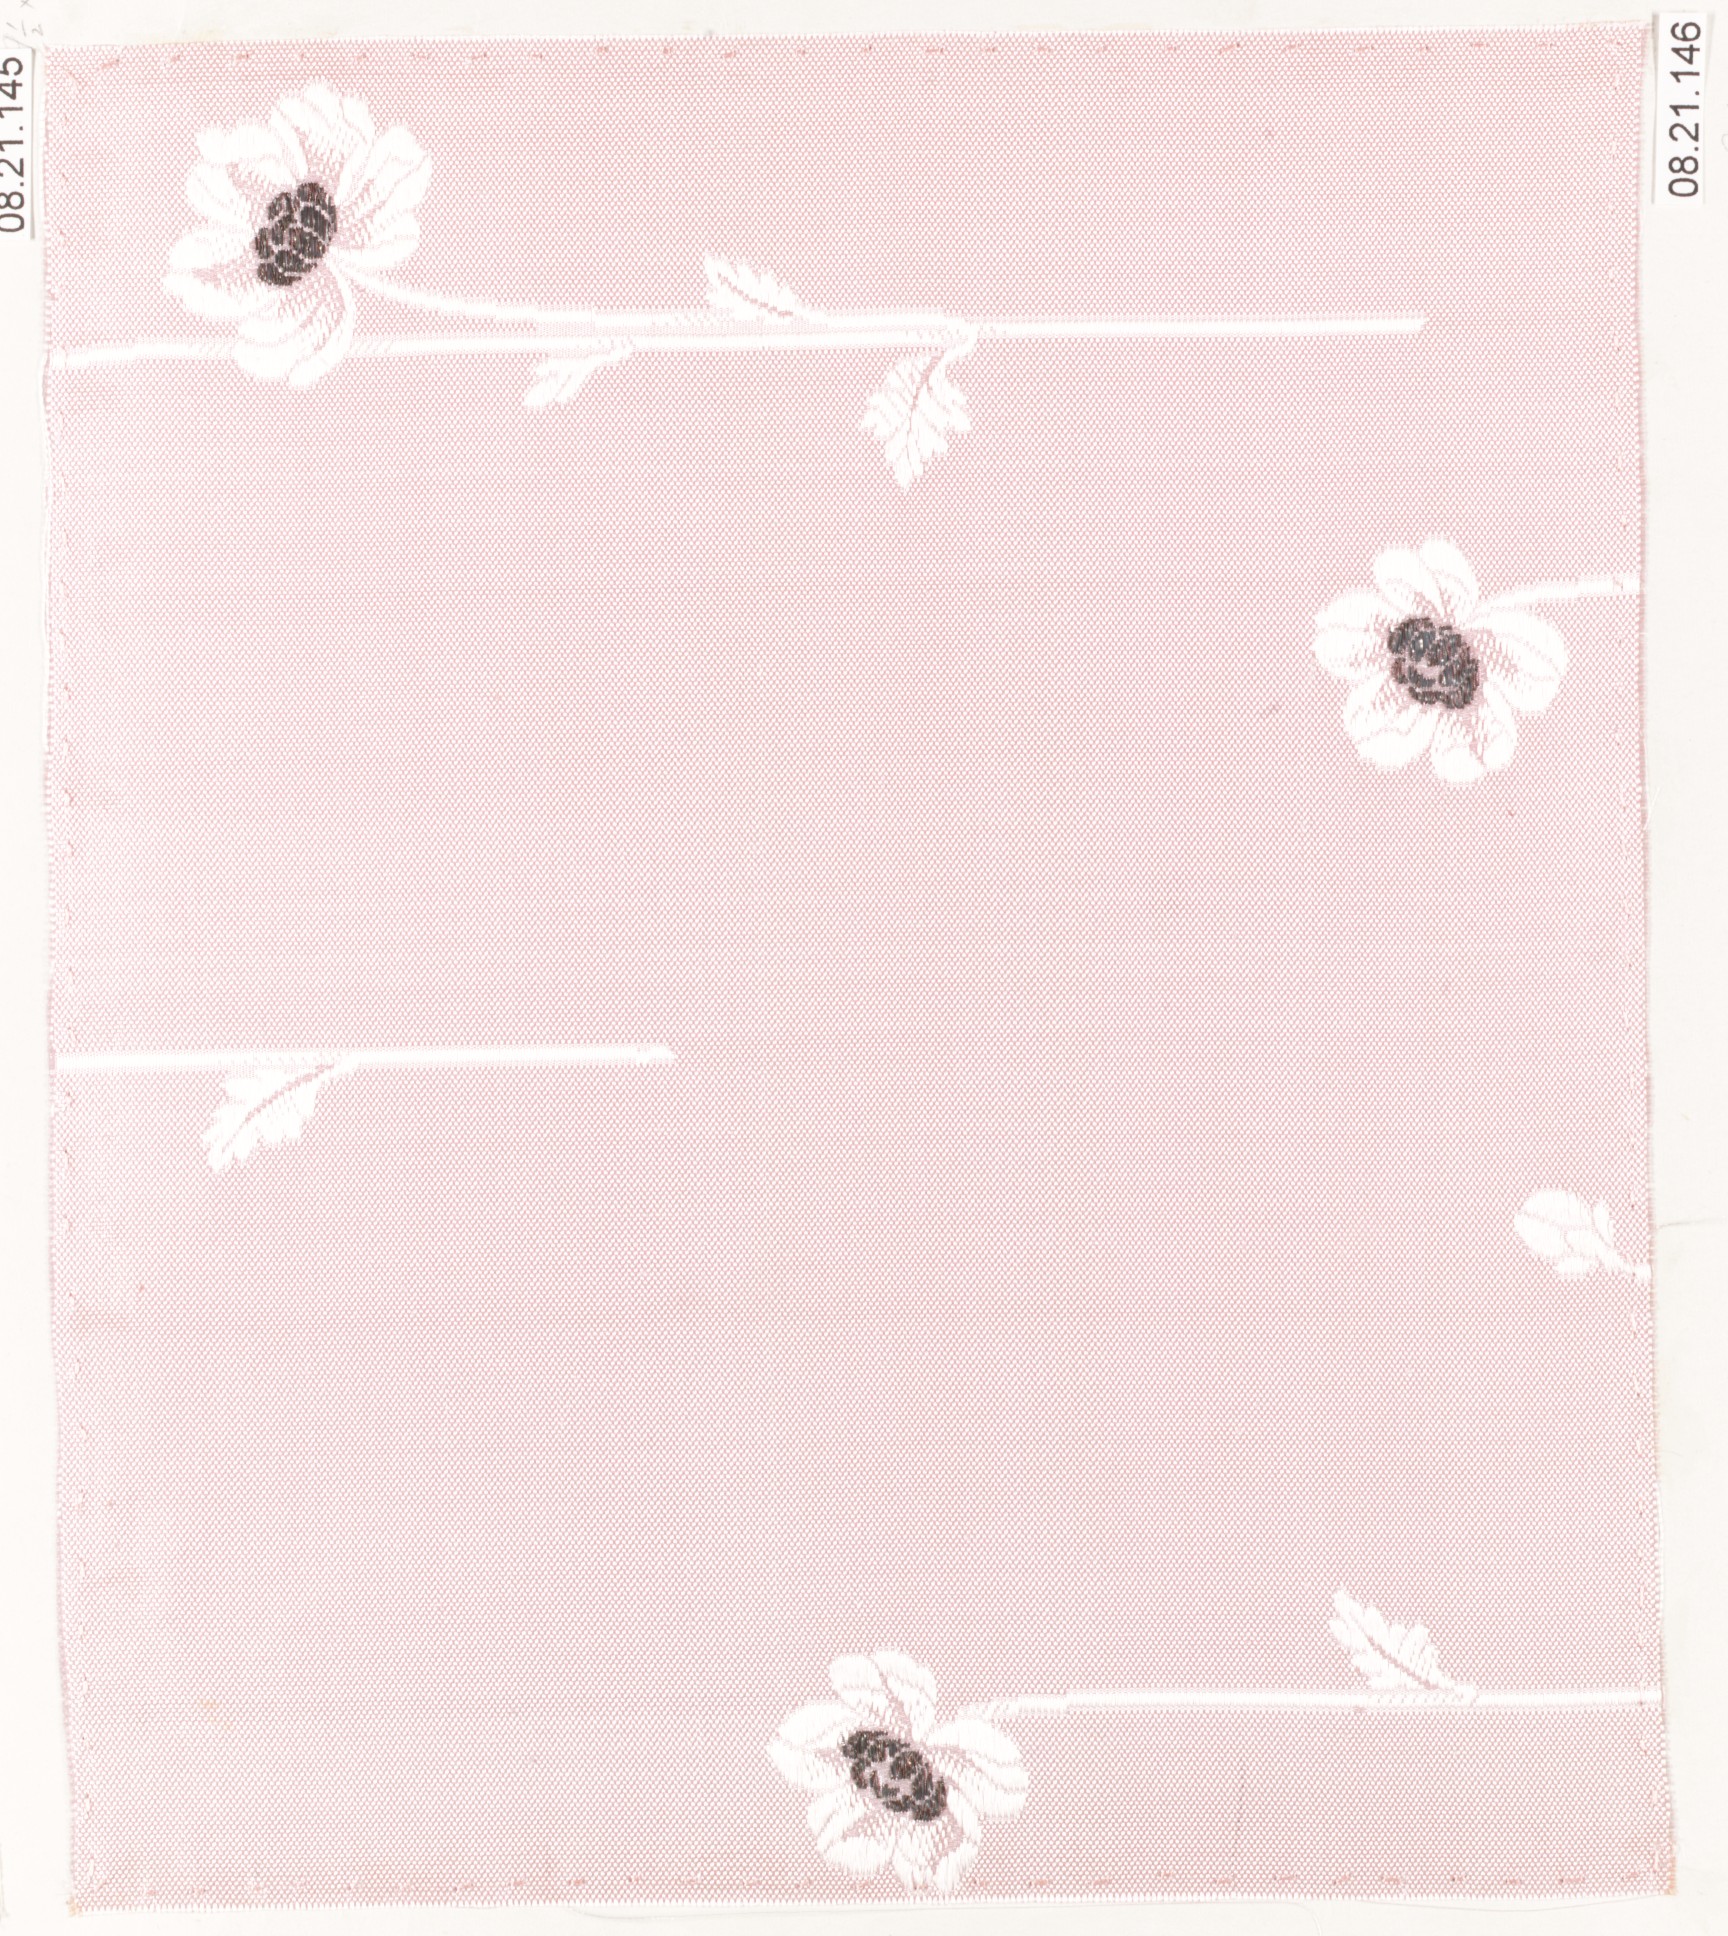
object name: textile sample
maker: Anonymous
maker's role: designer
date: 1900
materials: silk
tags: flowers